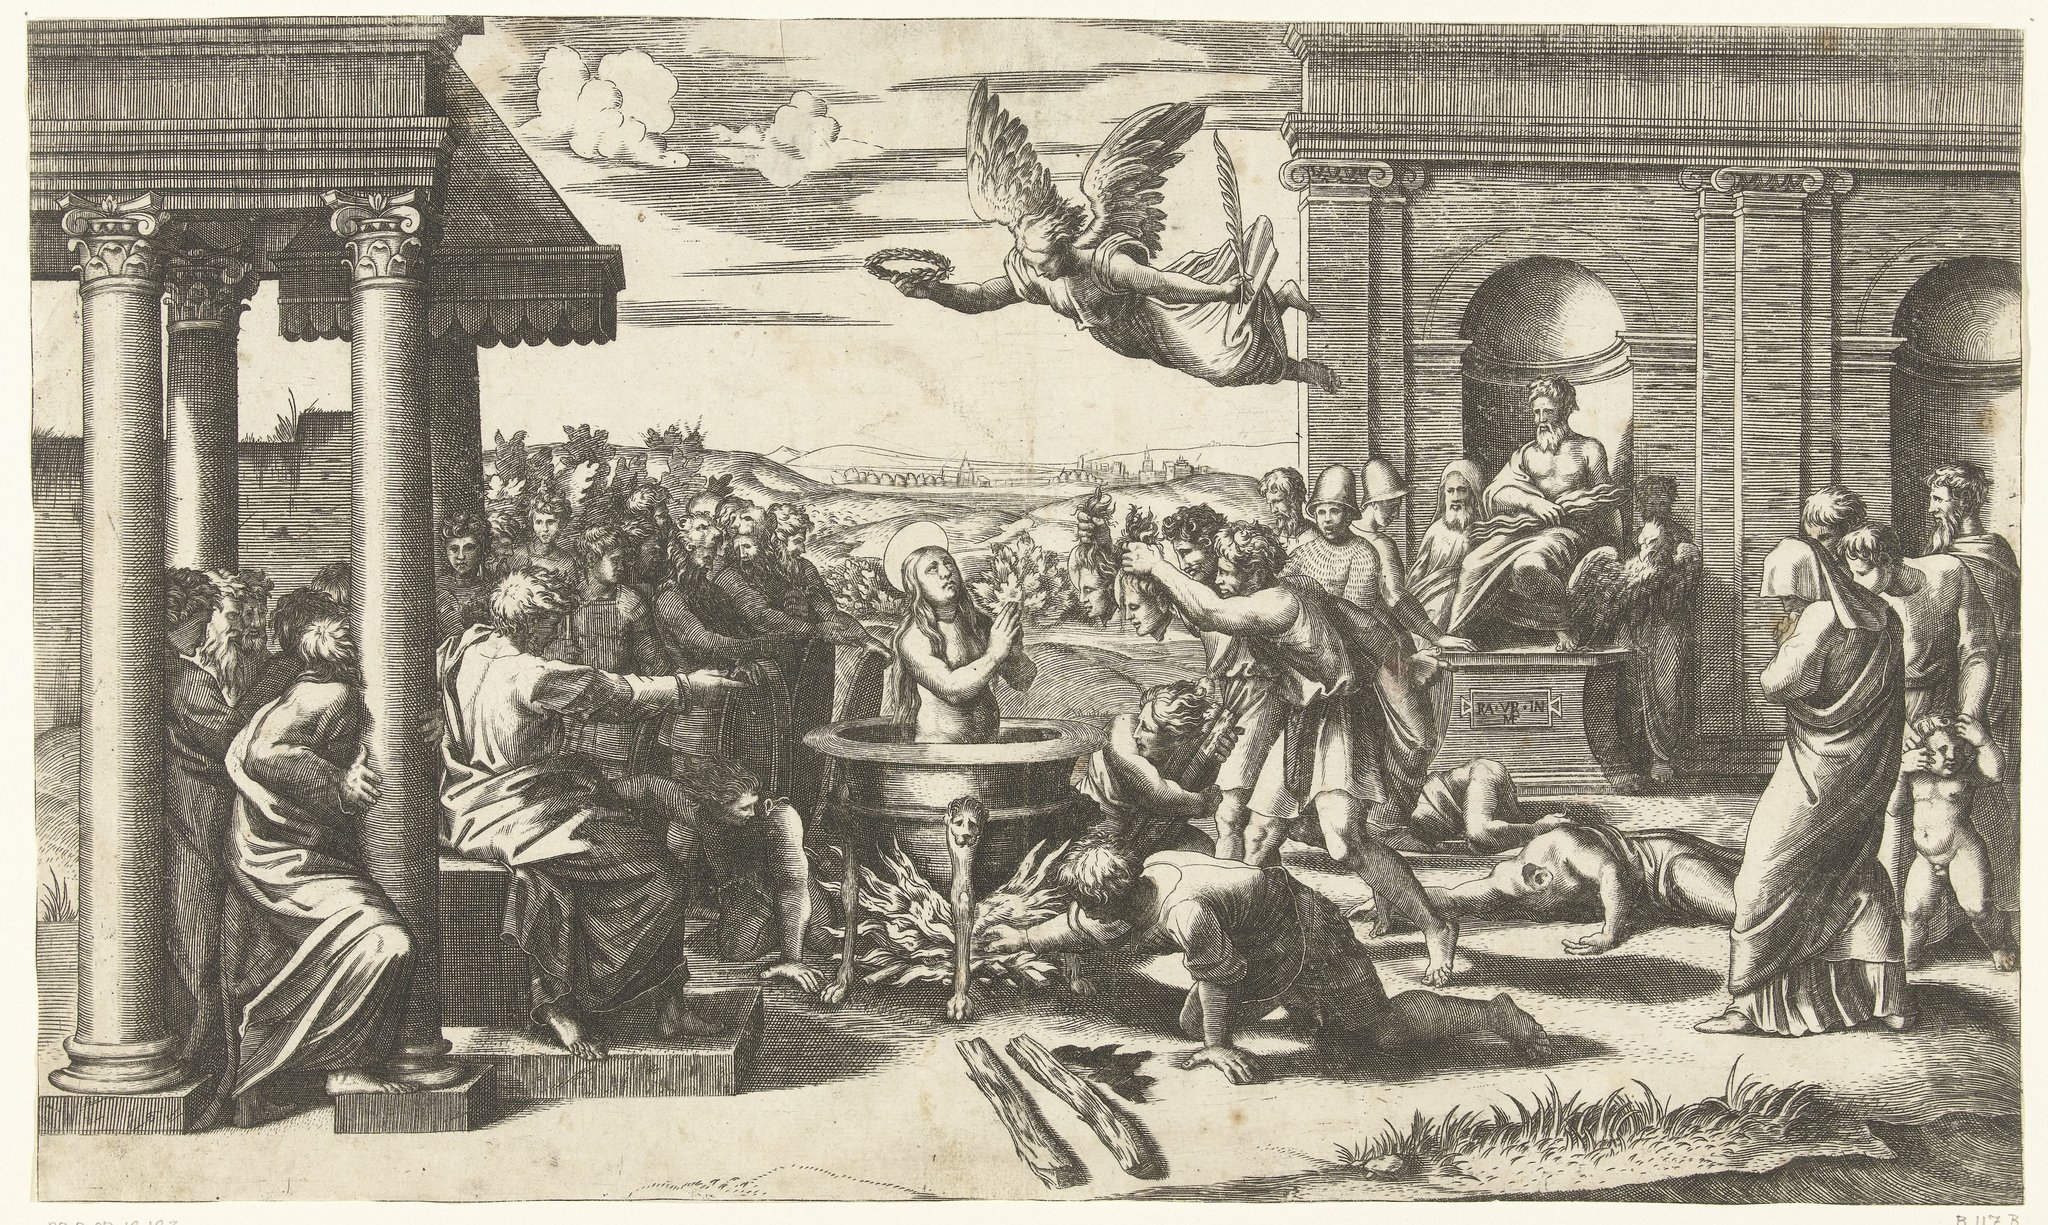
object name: print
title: Martelaarschap van de heilige Felicitas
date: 1520-1575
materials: paper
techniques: engraving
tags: st. cecilia is put in a cauldron of boiling oil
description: Kopie naar prent van Marcantonio Raimondi. Raimondi baseerde zich op een ontwerp van Raphael.